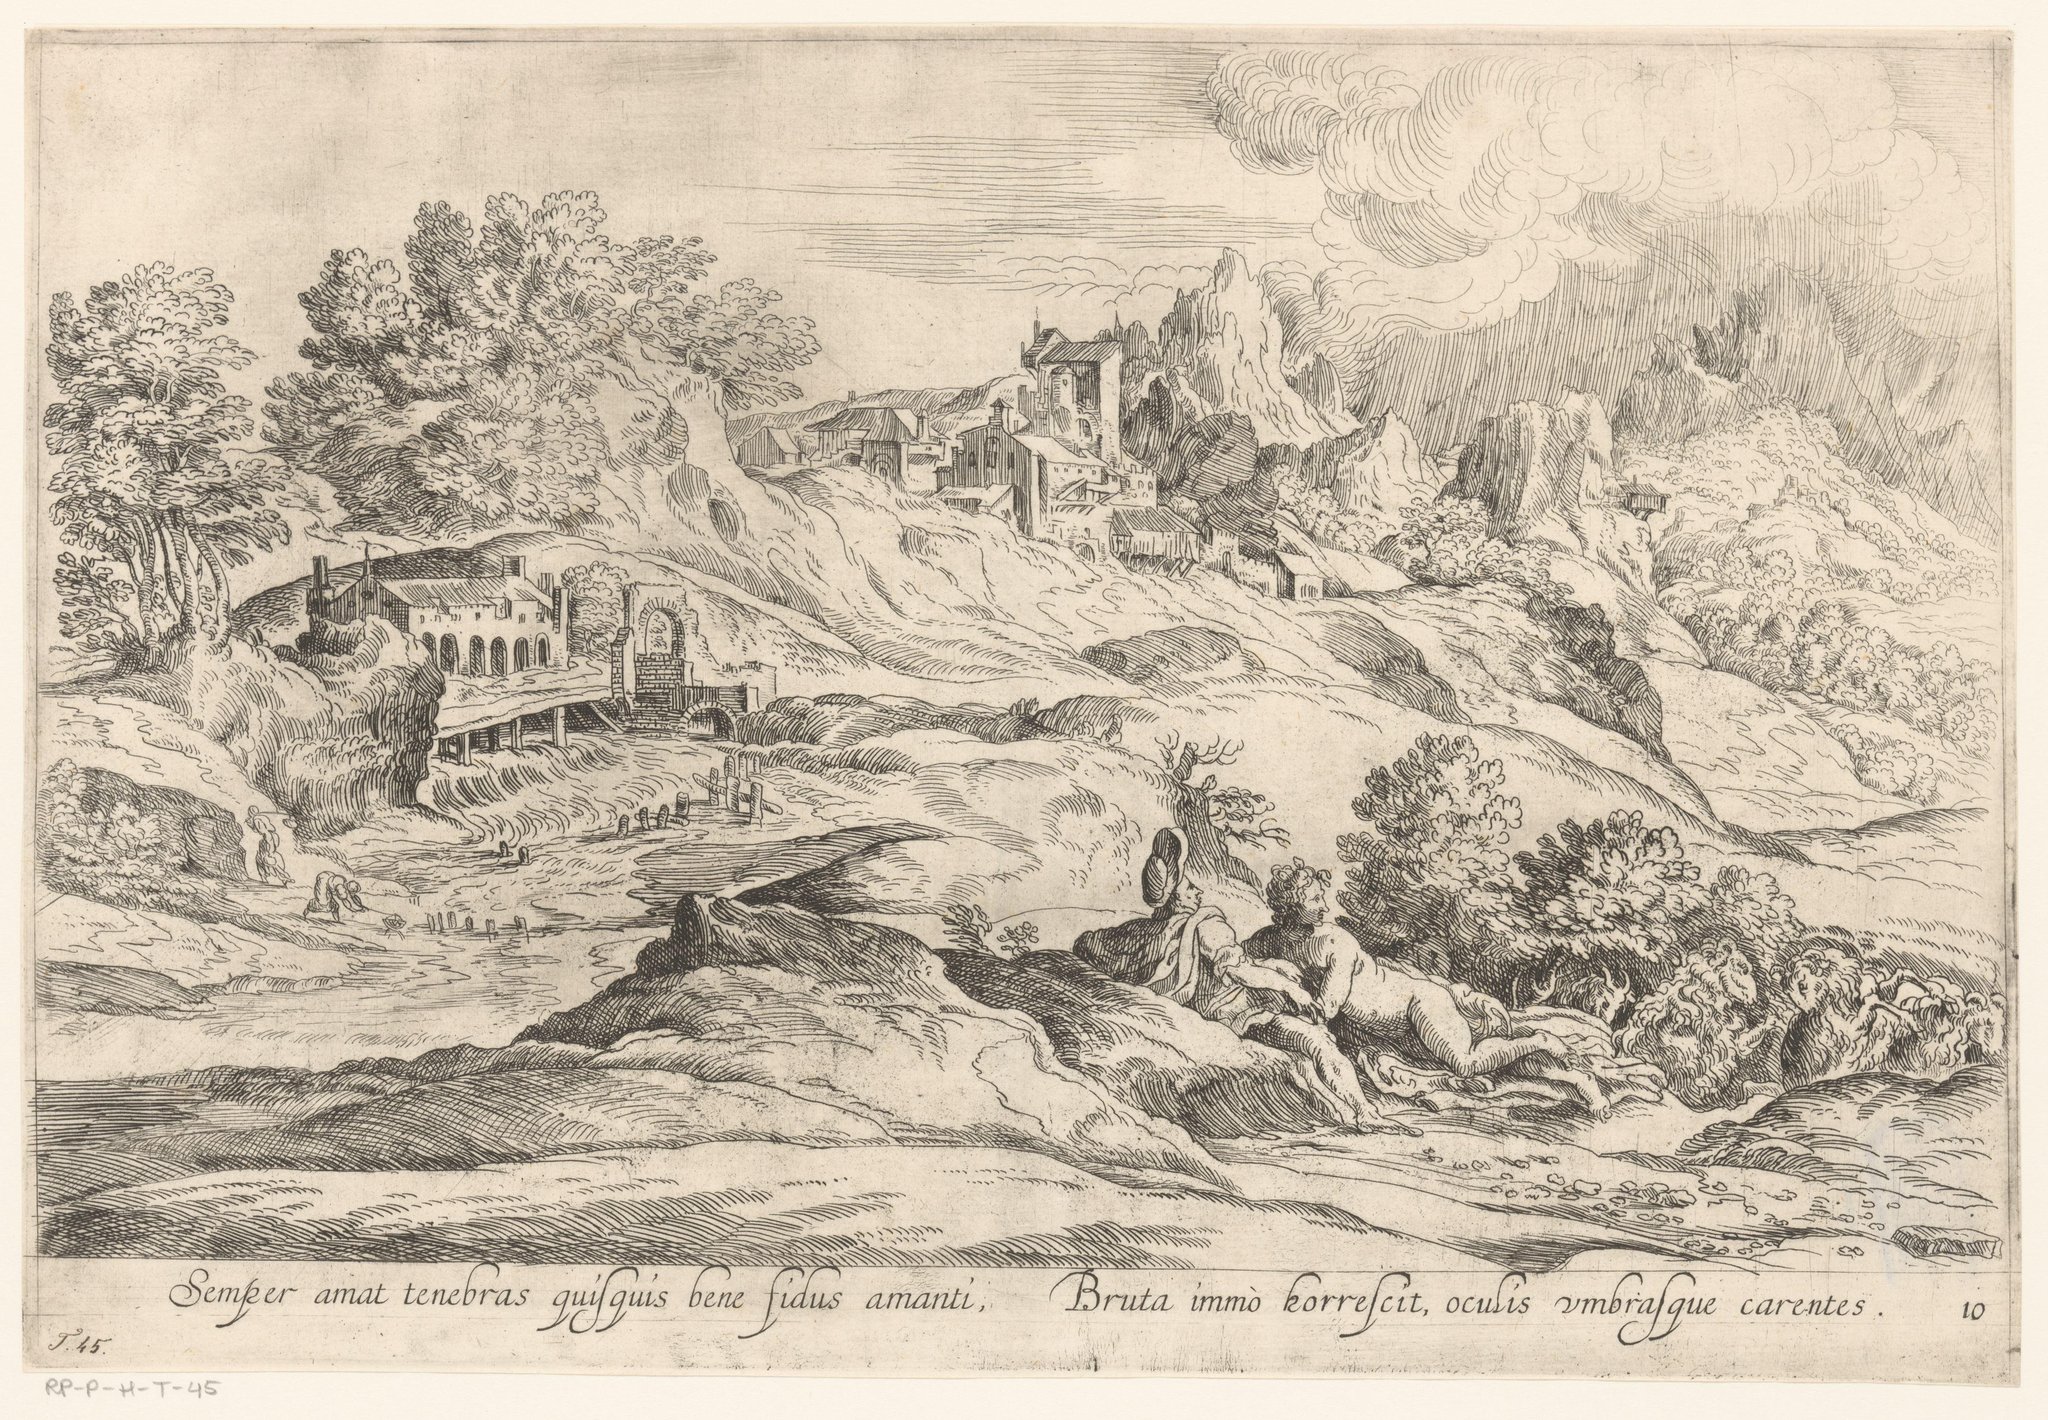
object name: print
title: Landschappen naar Domenico Campagnola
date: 1600-1699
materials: paper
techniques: etching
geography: italy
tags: landscapes, he-goat, billy-goat, couple of lovers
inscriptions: number: ‘T. 45.’, collector's mark: ‘Hinloopen’, collector's mark: Lugt 11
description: Heuvellandschap met bebouwing, een stroom en op de voorgrond een minnend paar bij een kudde bokken. Titel in het Latijn in ondermarge. Genummerd rechtsonder: 10.